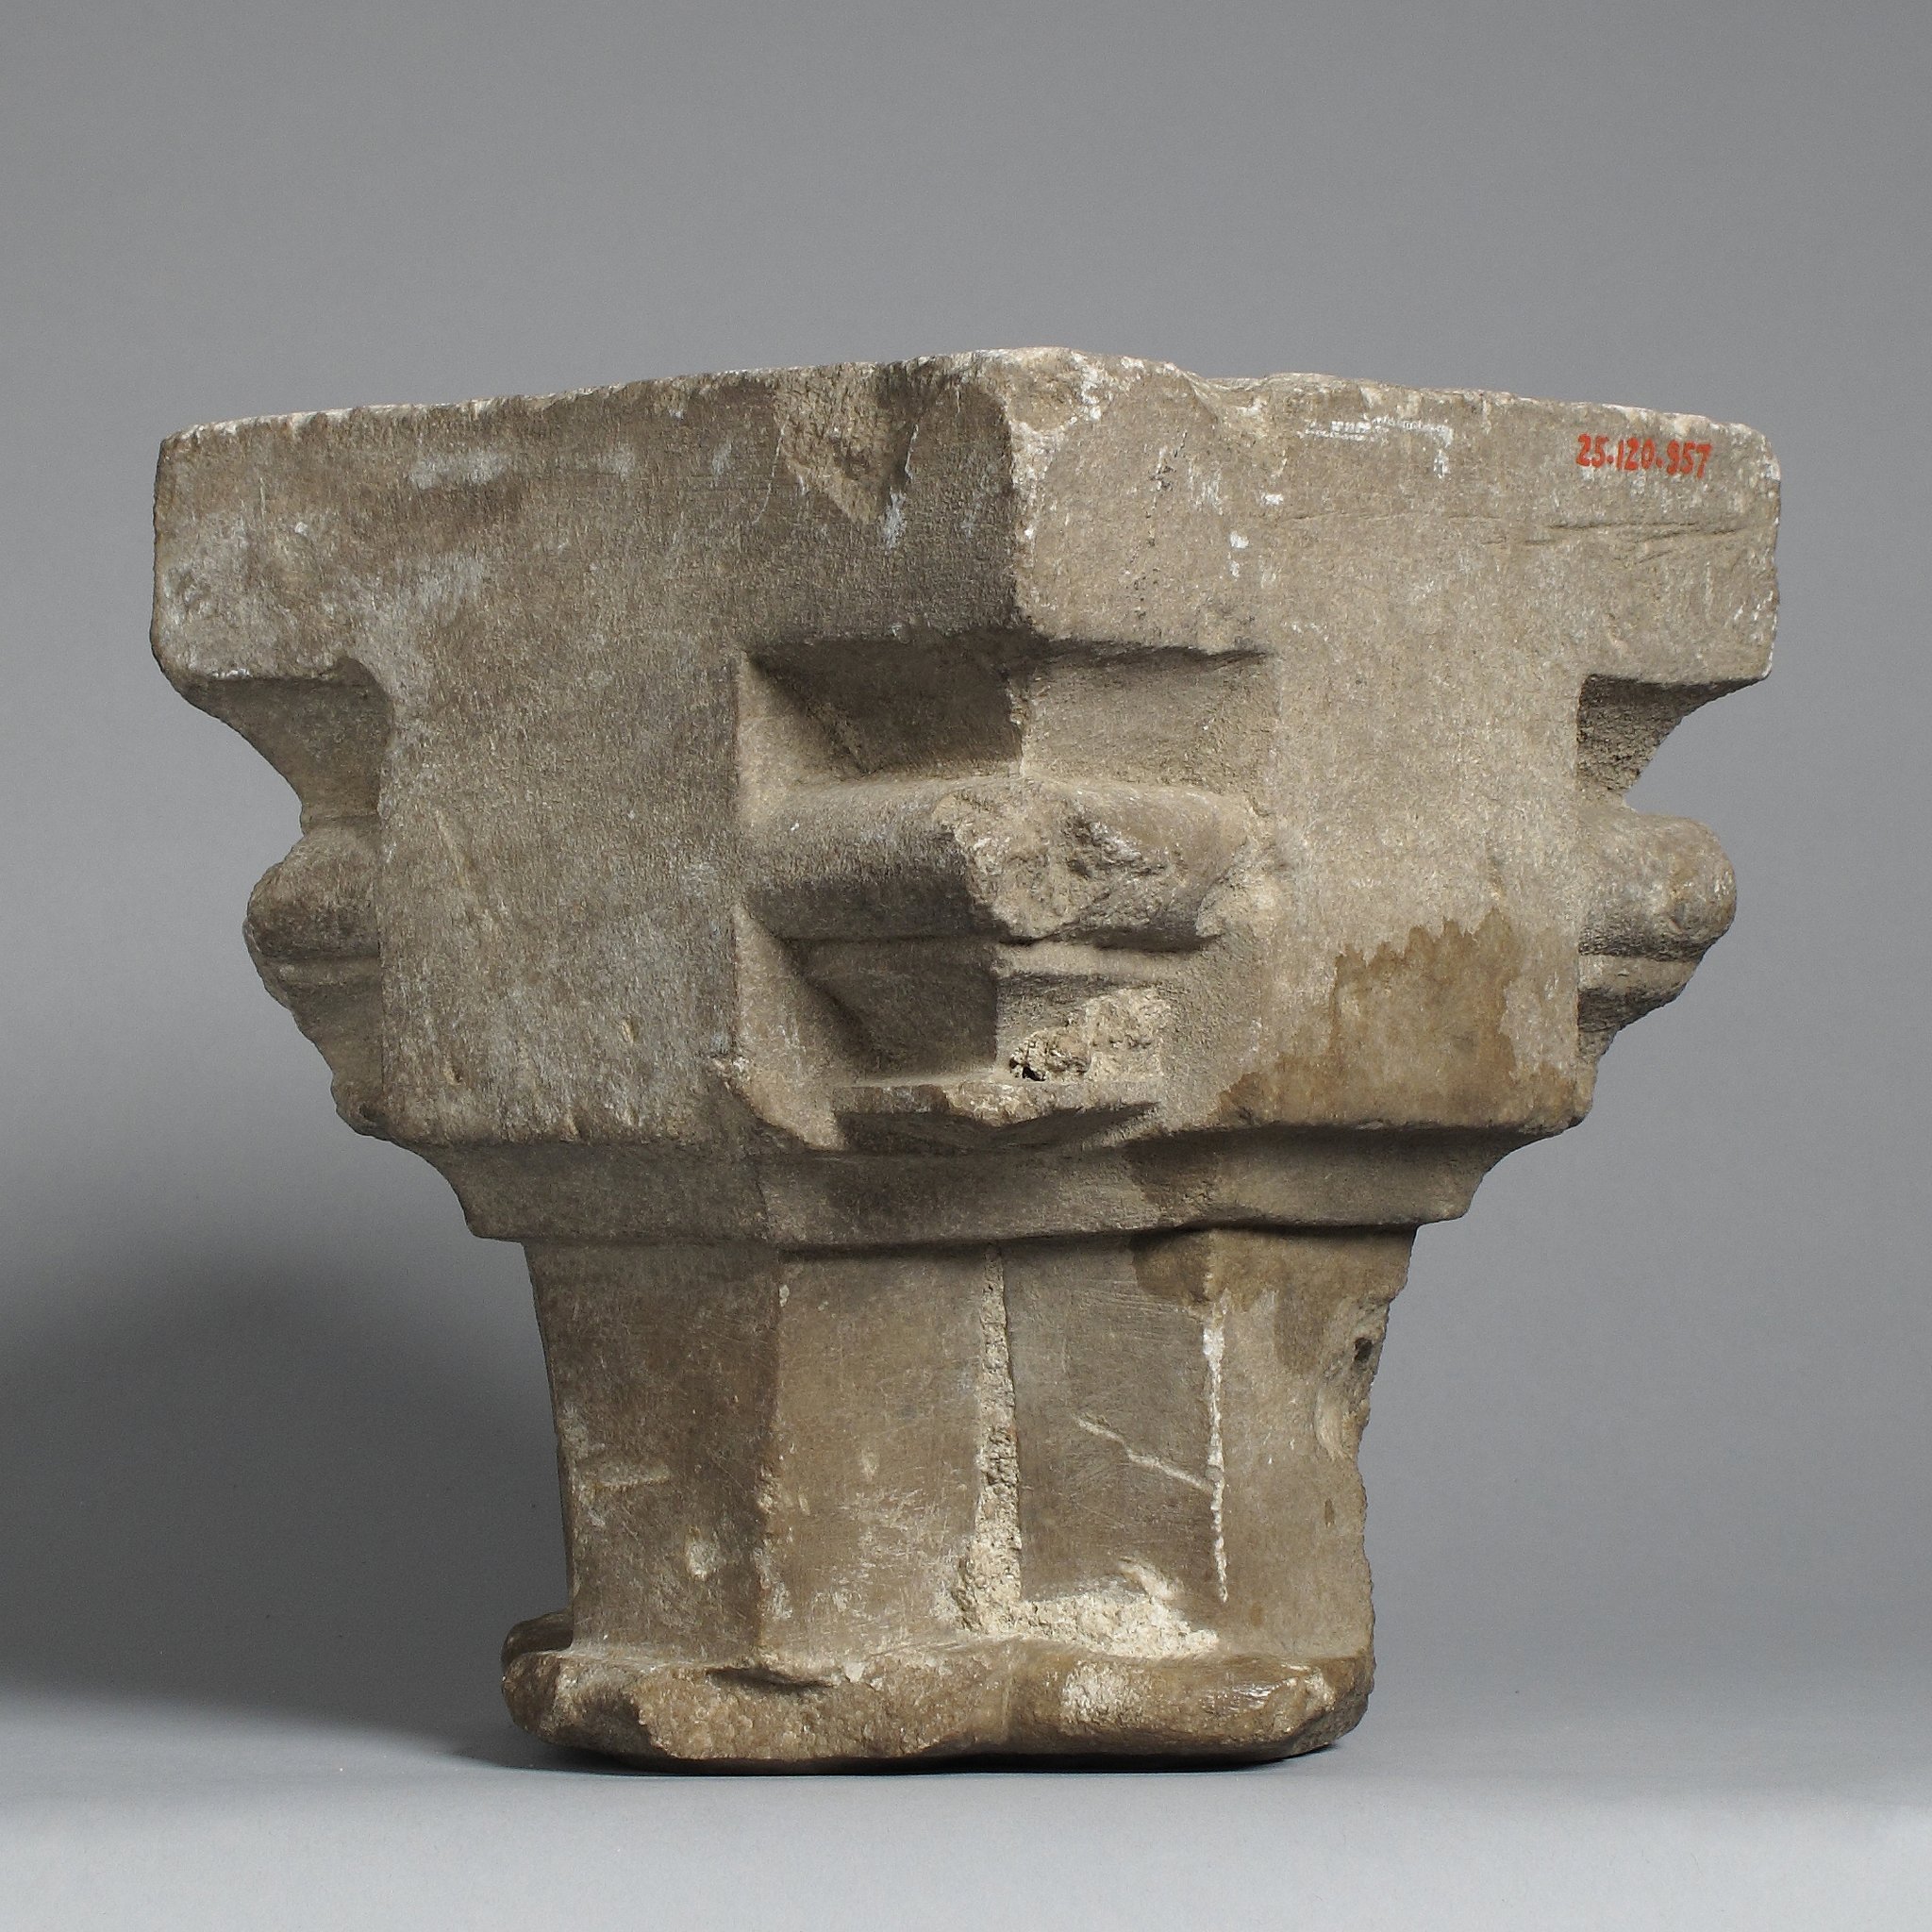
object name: capital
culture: french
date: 1301-1400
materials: stone